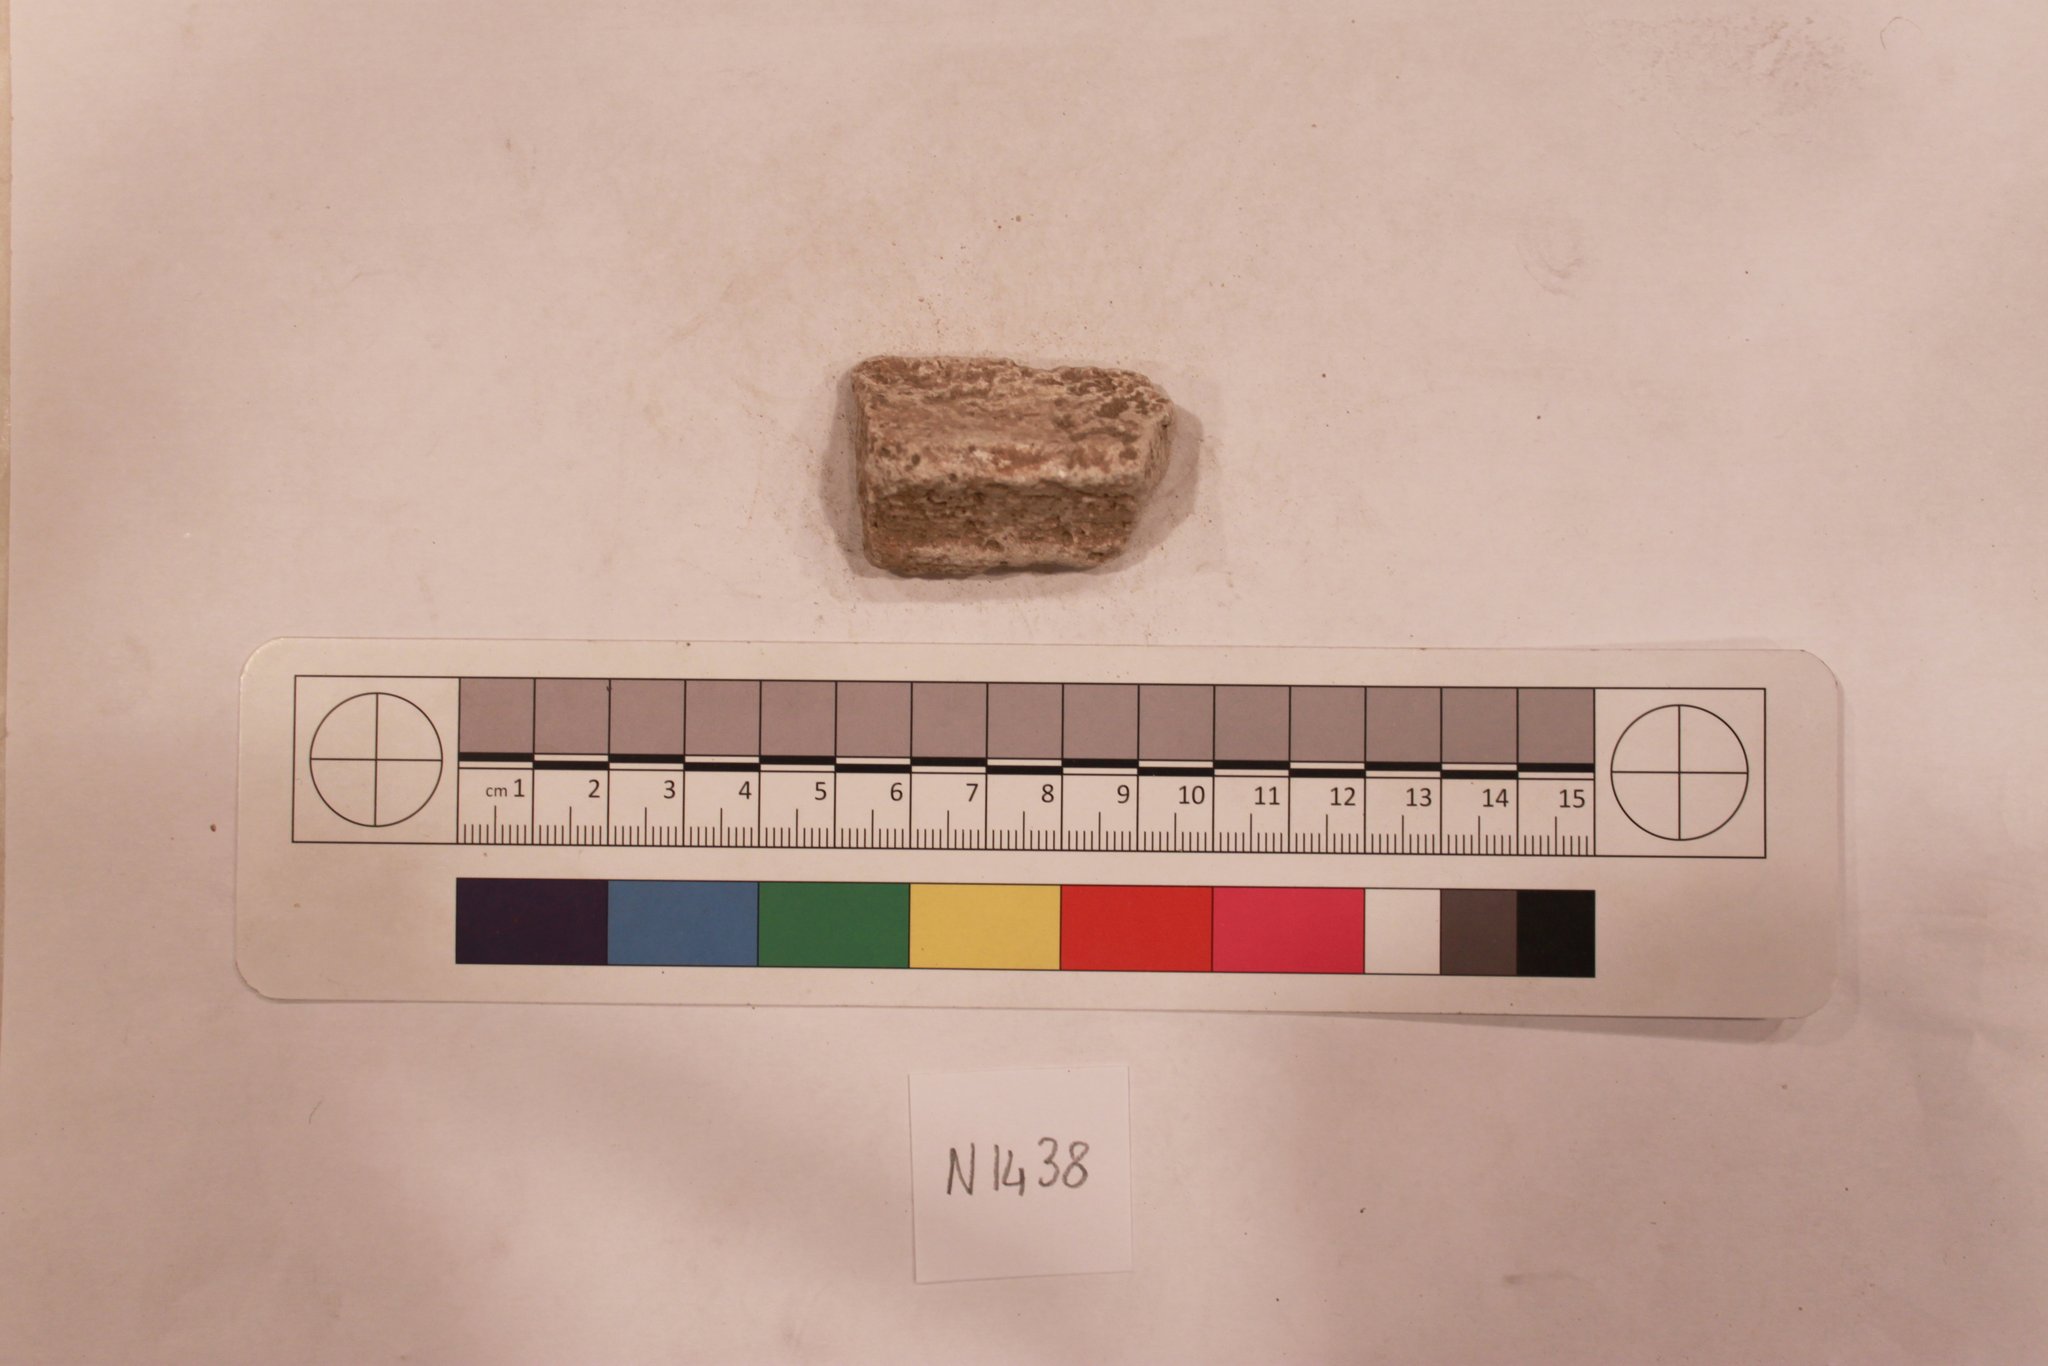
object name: fragment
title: Stucco Fragment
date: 701-1200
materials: plaster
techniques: carving, painting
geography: iran